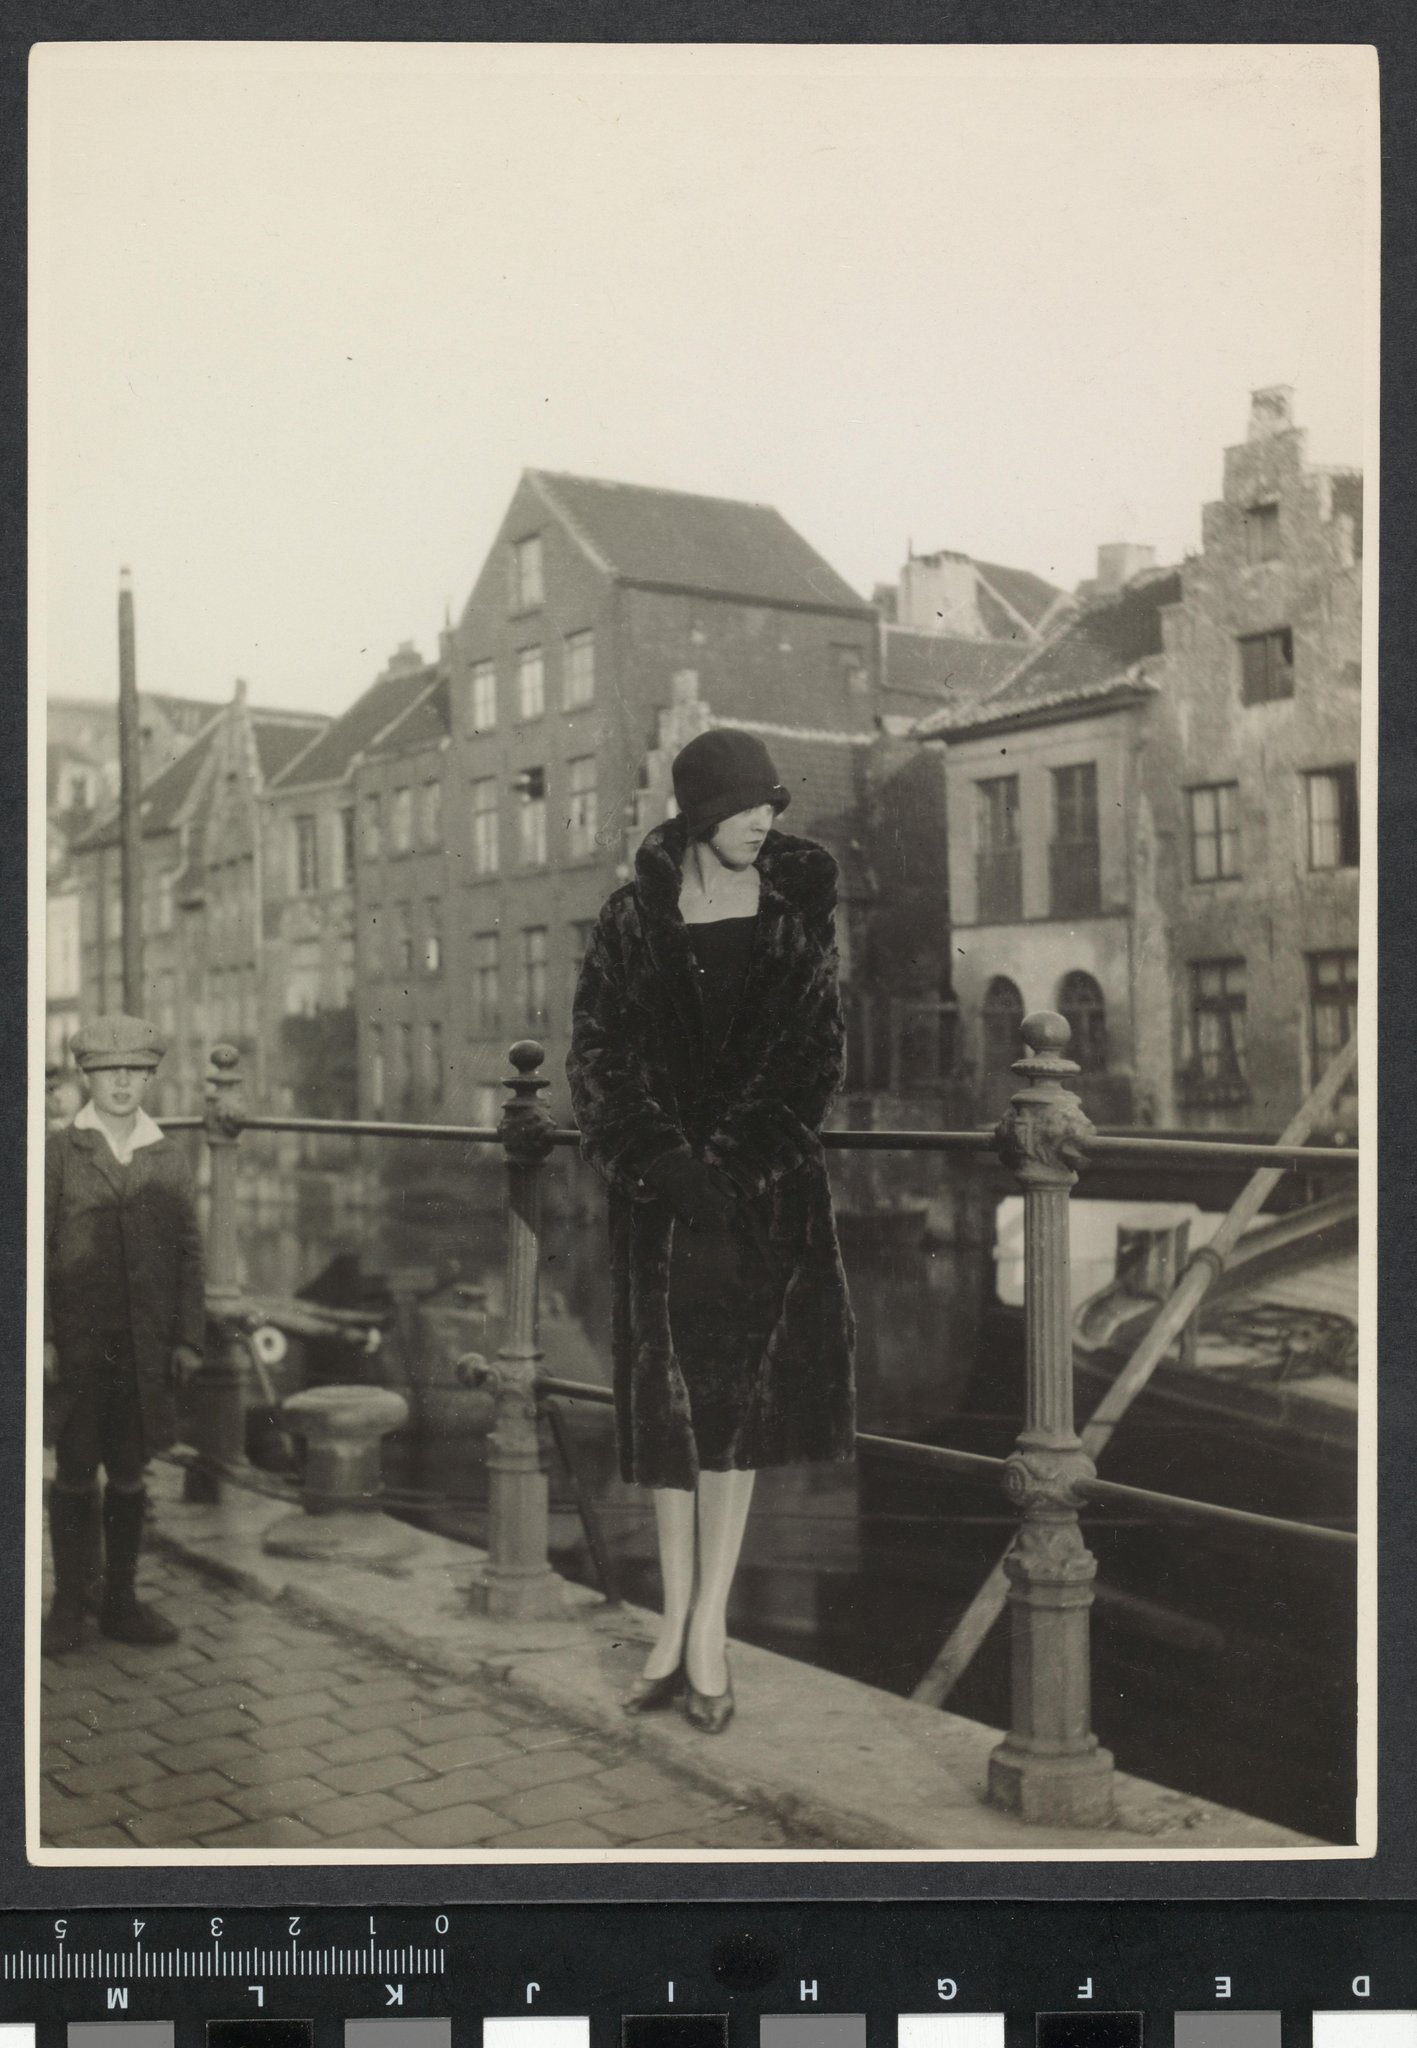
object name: photograph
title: Portret van G.A. Urtebise in bontjas met pothoed staand tegen de reling van een gracht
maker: Anonymous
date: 1920-1925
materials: photographic support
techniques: gelatin silver print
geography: belgium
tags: amsterdam, head-gear: hat, model, mannequin, coat, cape, belgium